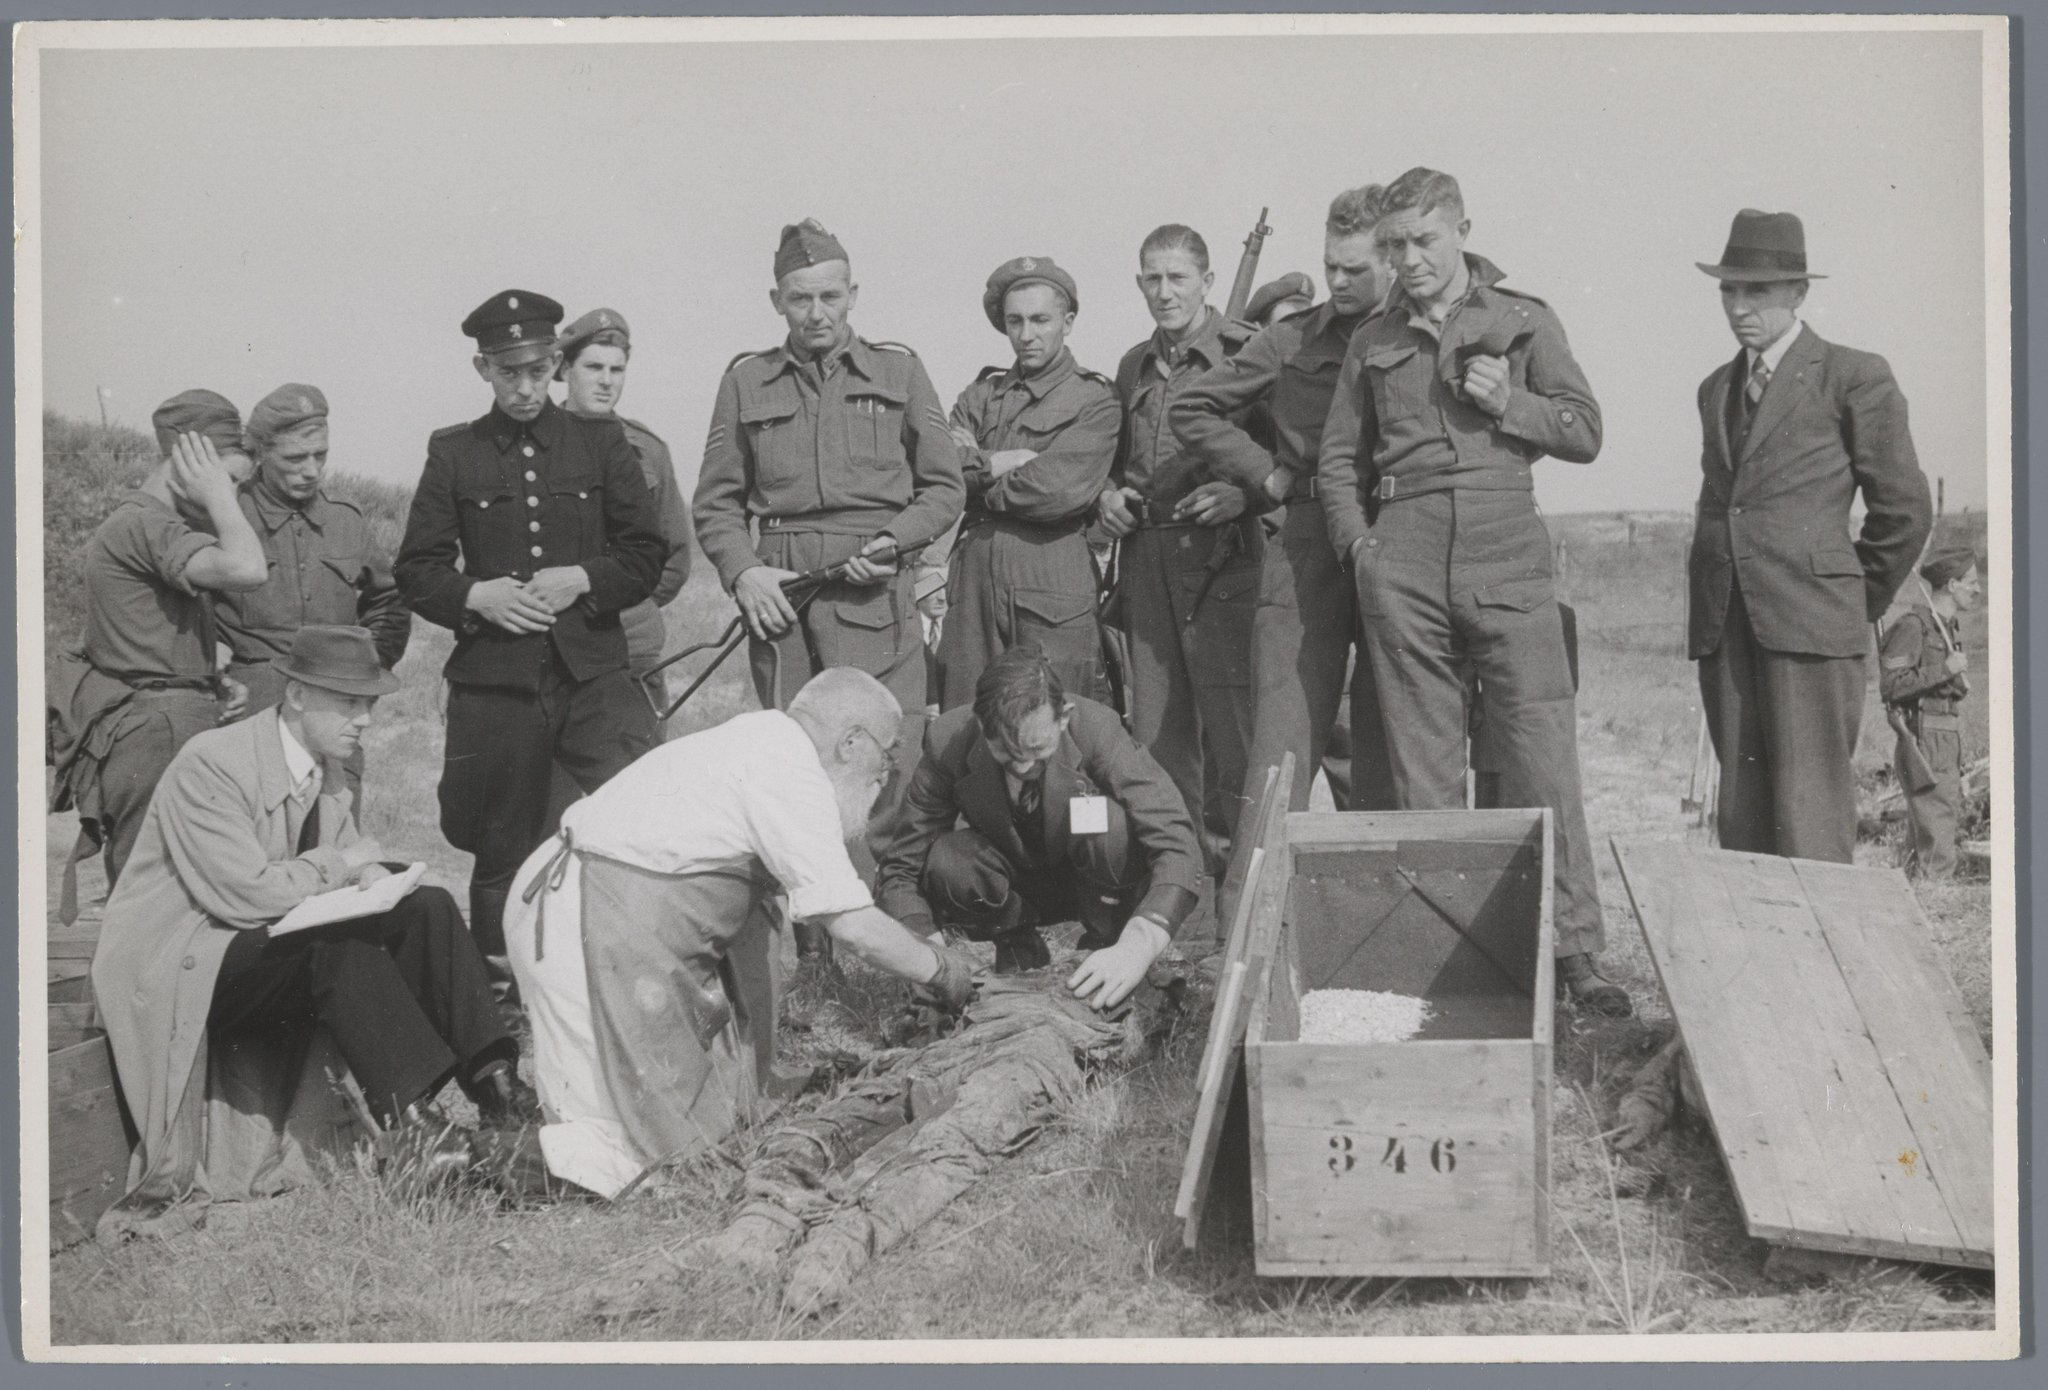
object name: photograph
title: Opgraving van de geëxecuteerden op de Waalsdorpervlakte en identificatie van de doden, juni 1945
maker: Anonymous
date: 1906-1945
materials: photographic support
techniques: gelatin silver print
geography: the hague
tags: opening of grave, exhumation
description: Serie toont het opgraven van geëxecuteerden op de Waalsdorpervlakte in juni 1945, dus kort na het einde van de oorlog. De reeks toont het opsporen van de lijken, het uitgraven en het onderzoek door een patholoog anatoom. Ook het verplaatsen van de lijken en onderbrengen in nieuwe doodskisten is in beeld gebracht. Alles gebeurt in aanwezigheid van Nederlandse militairen, een tweetal Duitse militairen in uniform. Opgraven en het tillen van de kisten gebeurt door mannen in burger, vermoedelijk voormalige NSB'ers.